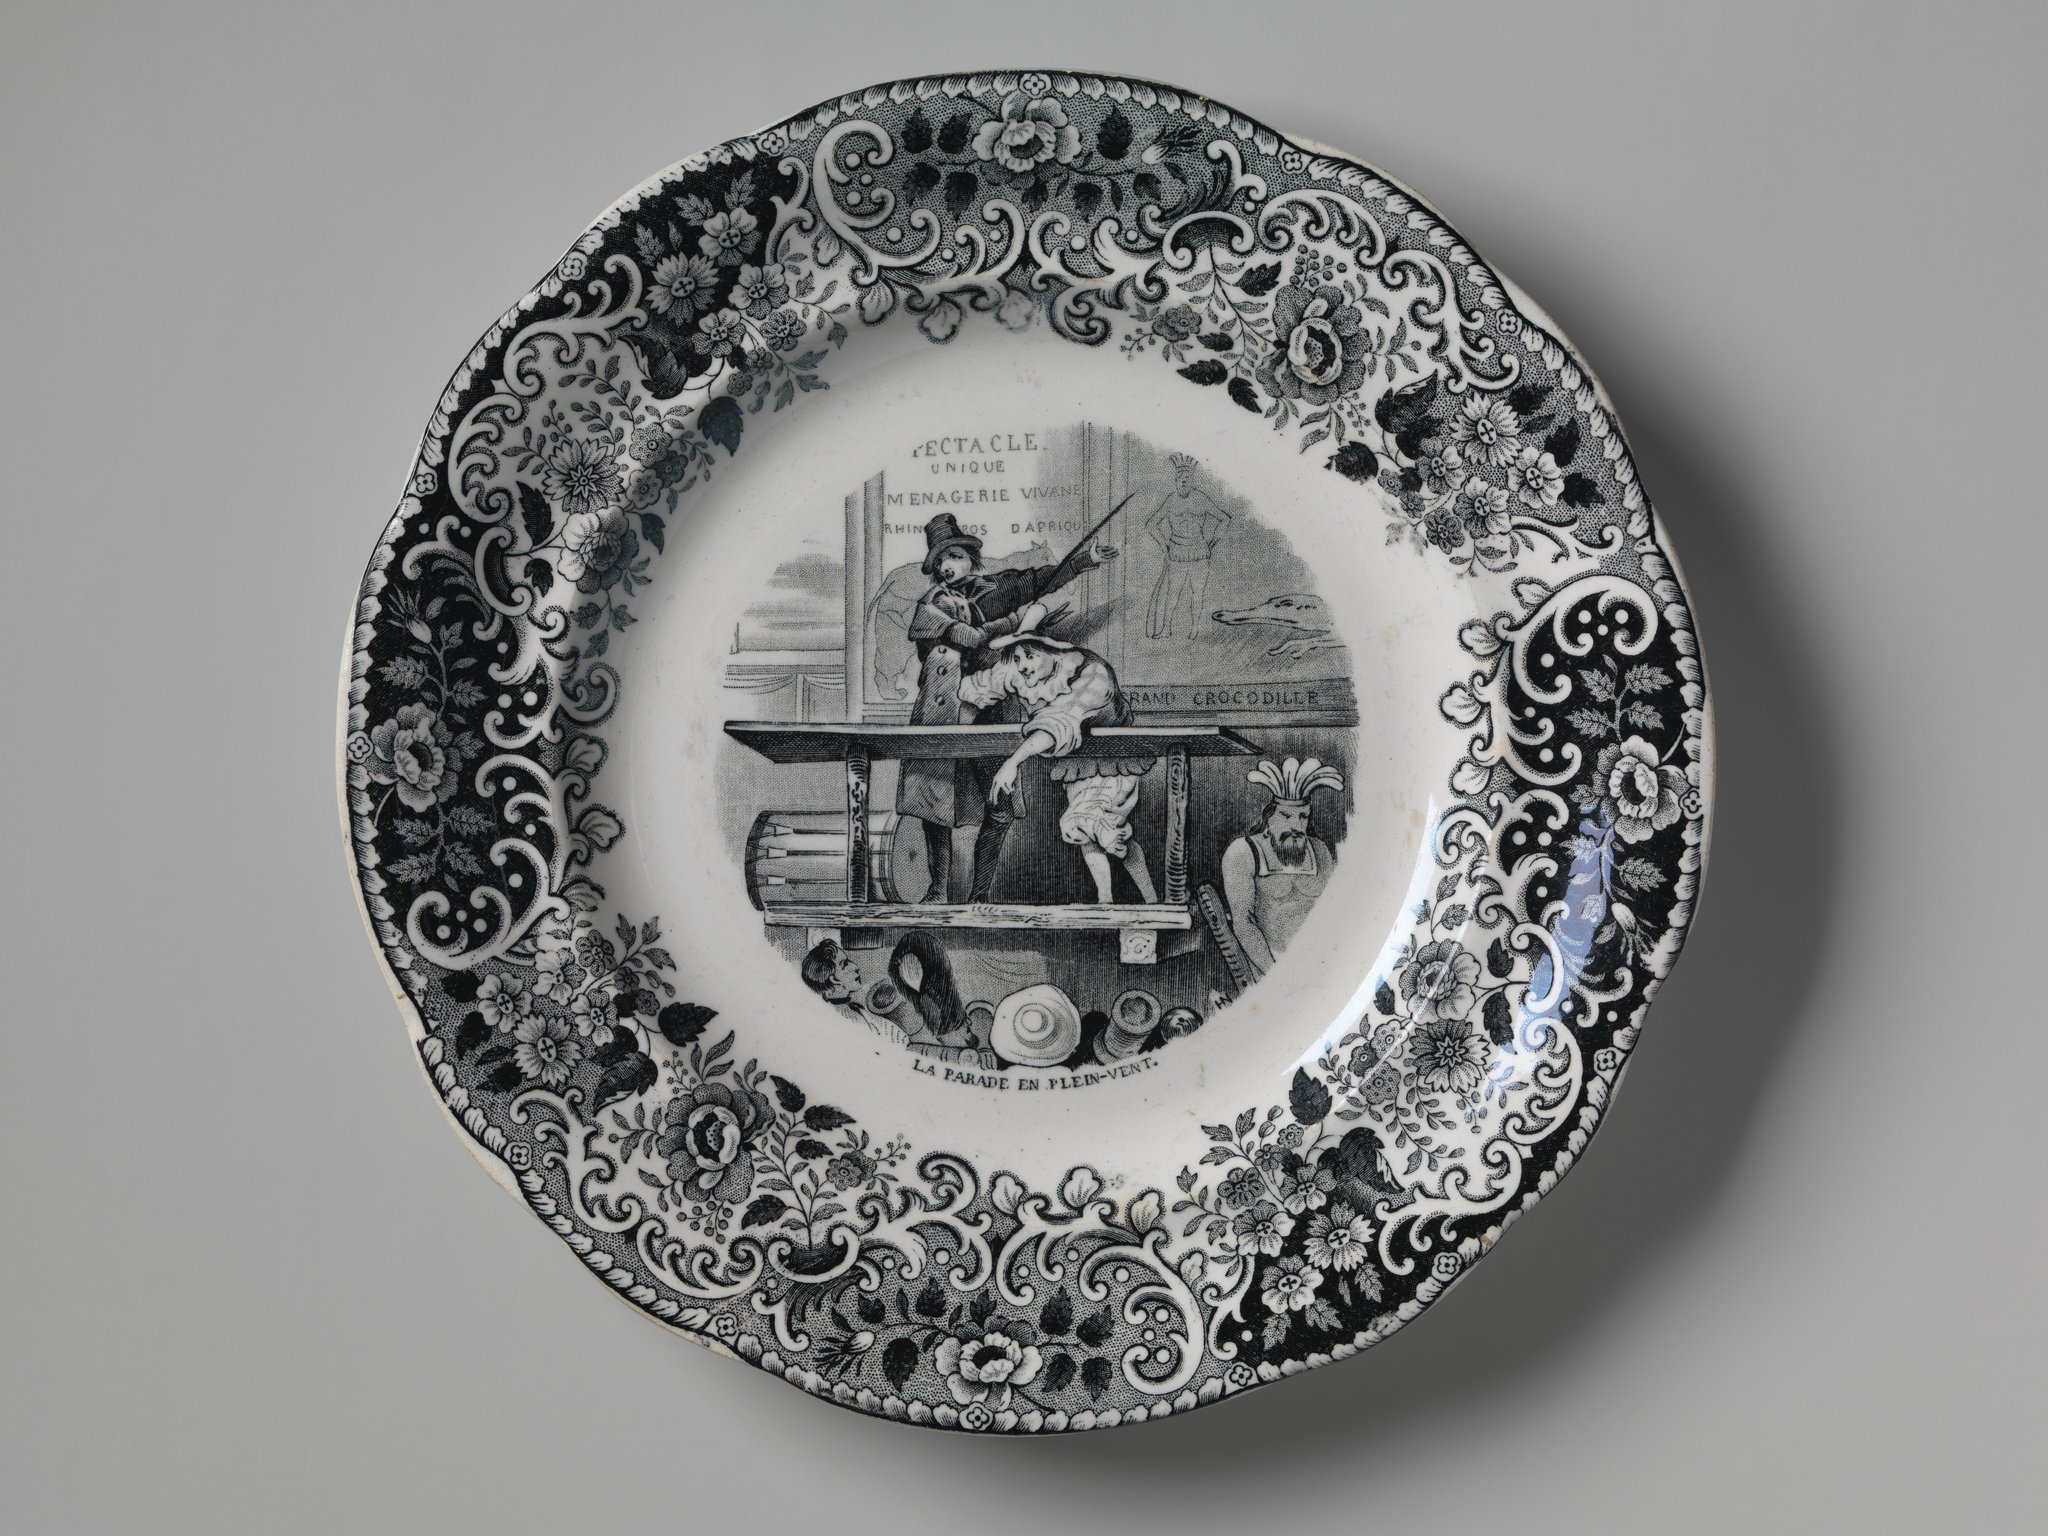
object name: plate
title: The Open-Air Sideshow (La Parade en plein-vent)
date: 1850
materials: earthenware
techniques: transfer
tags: men,flowers